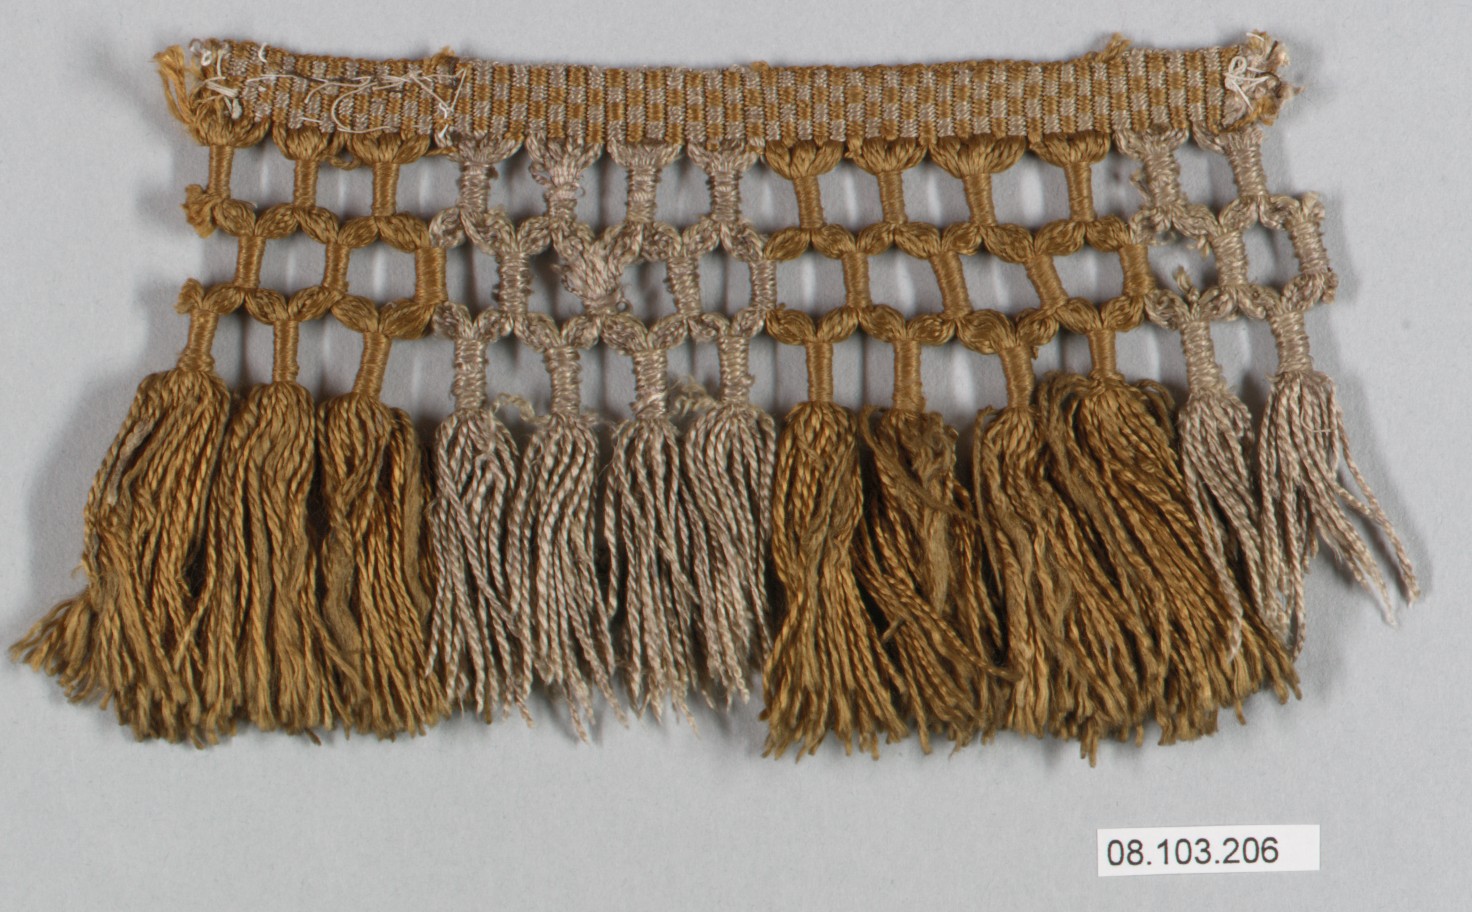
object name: fringe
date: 1801-1900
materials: silk